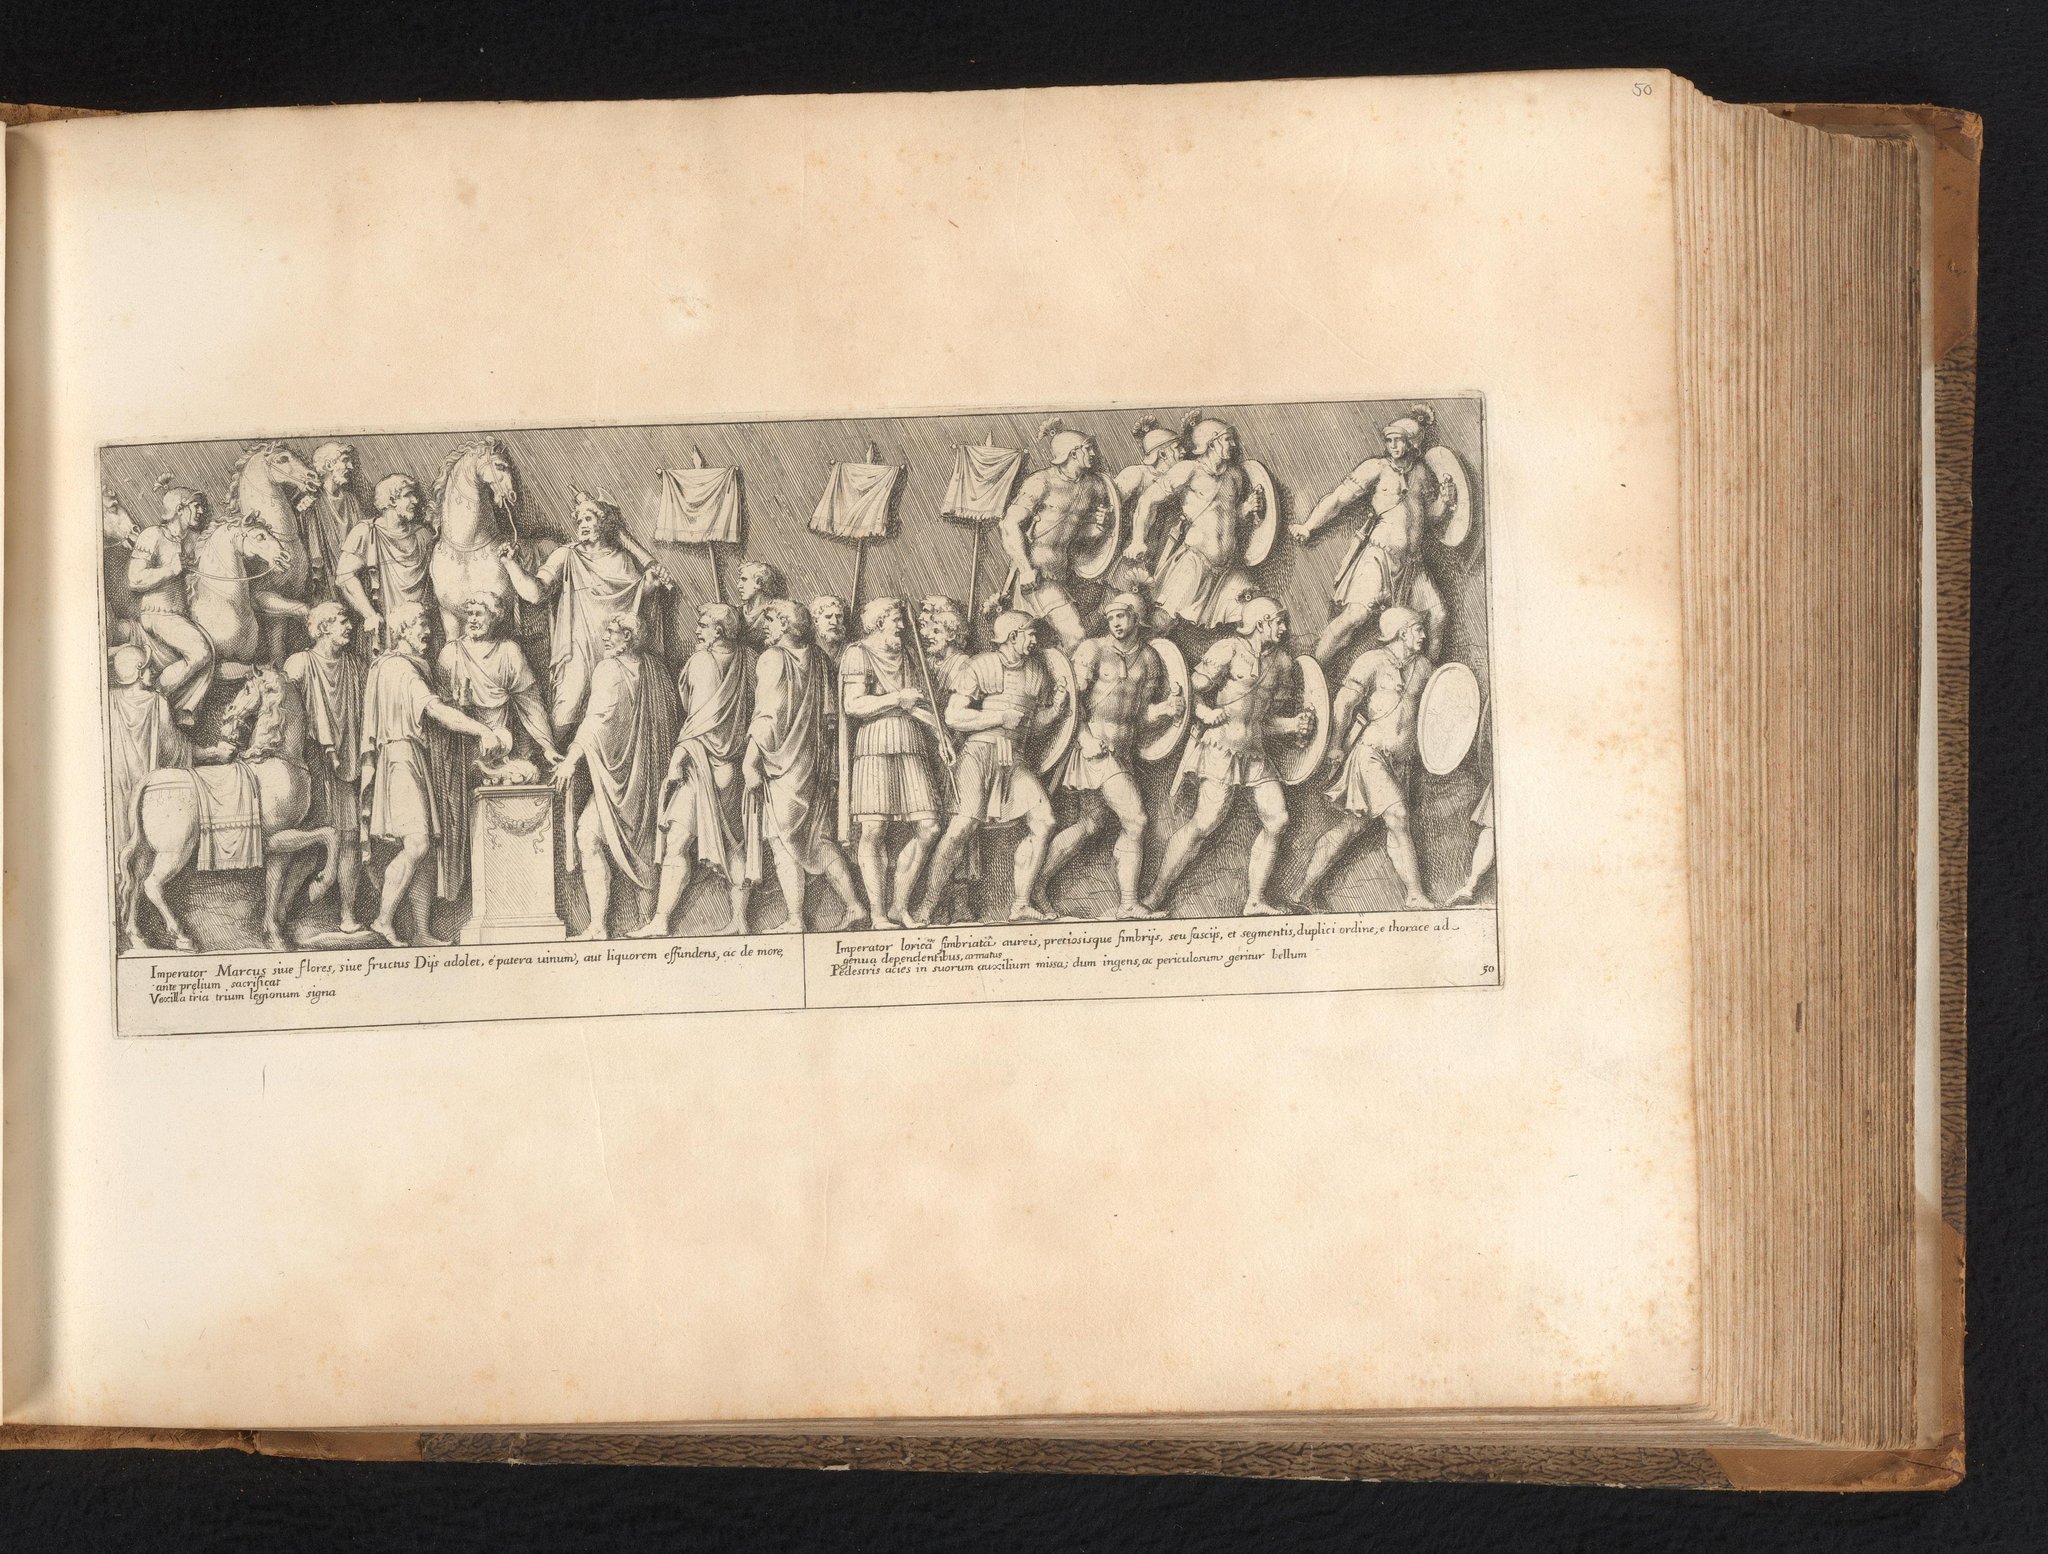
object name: print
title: Detail van het fries op de Zuil van Marcus Aurelius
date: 1672-1675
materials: paper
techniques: etching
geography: rome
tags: triumphal column with helical friezes, piece of sculpture, reproduction of a piece of sculpture, the soldier; the soldier's life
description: Detail van het spiraalvormige gebeeldhouwde fries op de Zuil van Marcus Aurelius te Rome. Het fries toont de oorlog tussen het Romeinse leger van keizer Marcus Aurelius en de Germaanse stammen der Marcomannen en Quaden en de oorlog tegen de Sarmaten die vanuit het huidige Iran Hongarije waren binnengevallen. Tekst in de ondermarge. Prent maakt deel uit van een album.